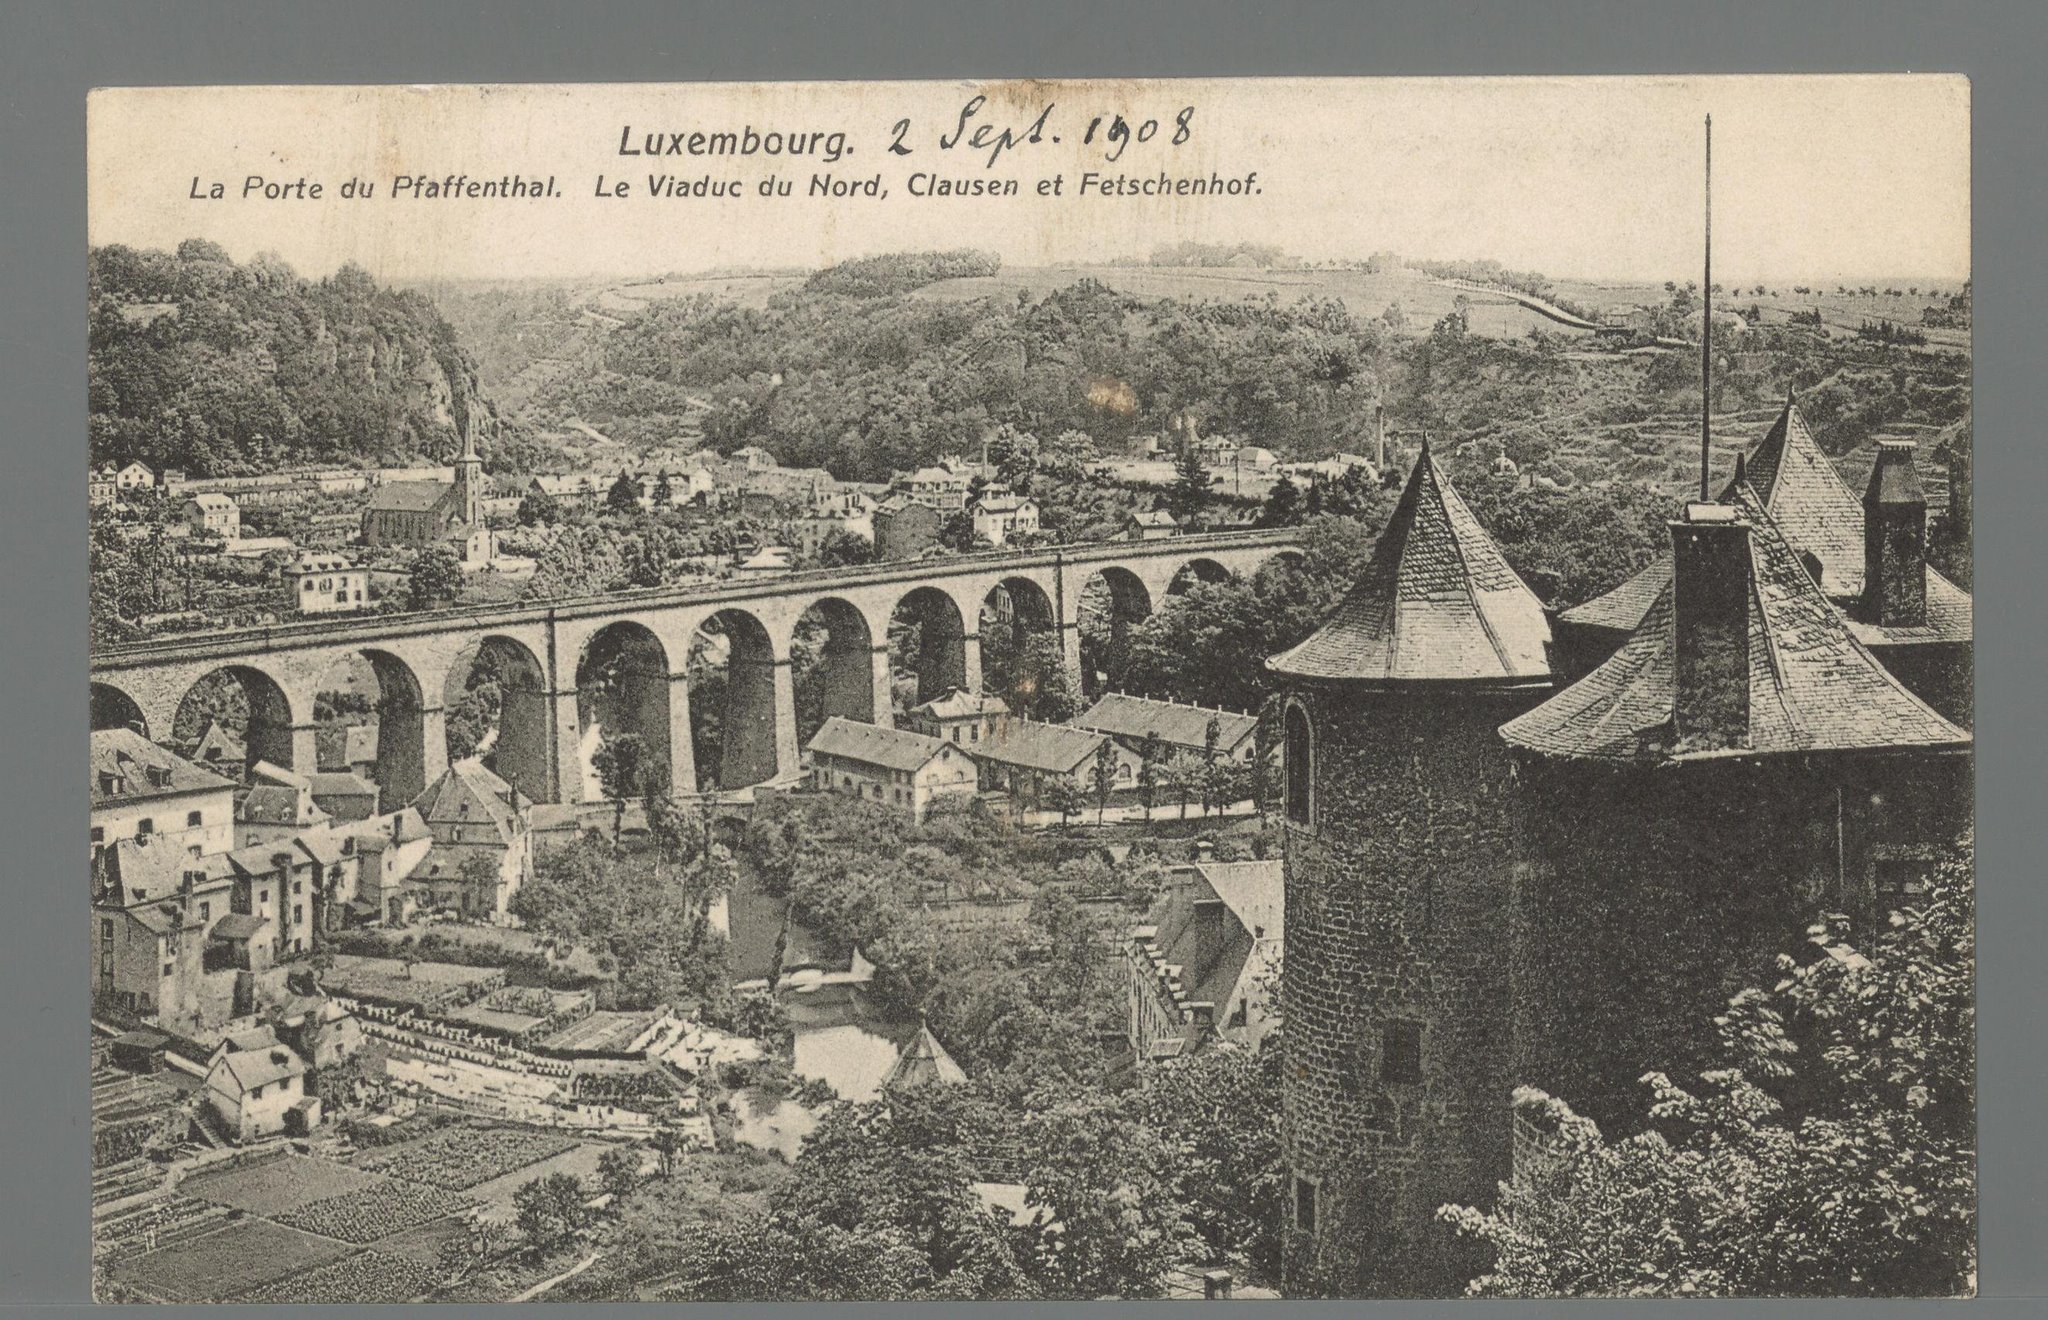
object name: photomechanical print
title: Luxembourg. La Porte du Pfaffenthal. Le Viaduc du Nord, Clausen et Fetschenhof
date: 1906-1908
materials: cardboard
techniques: photograph, writing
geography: luxembourg city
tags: landscape with bridge, viaduct or aqueduct, church (exterior), city-gate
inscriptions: postage stamp